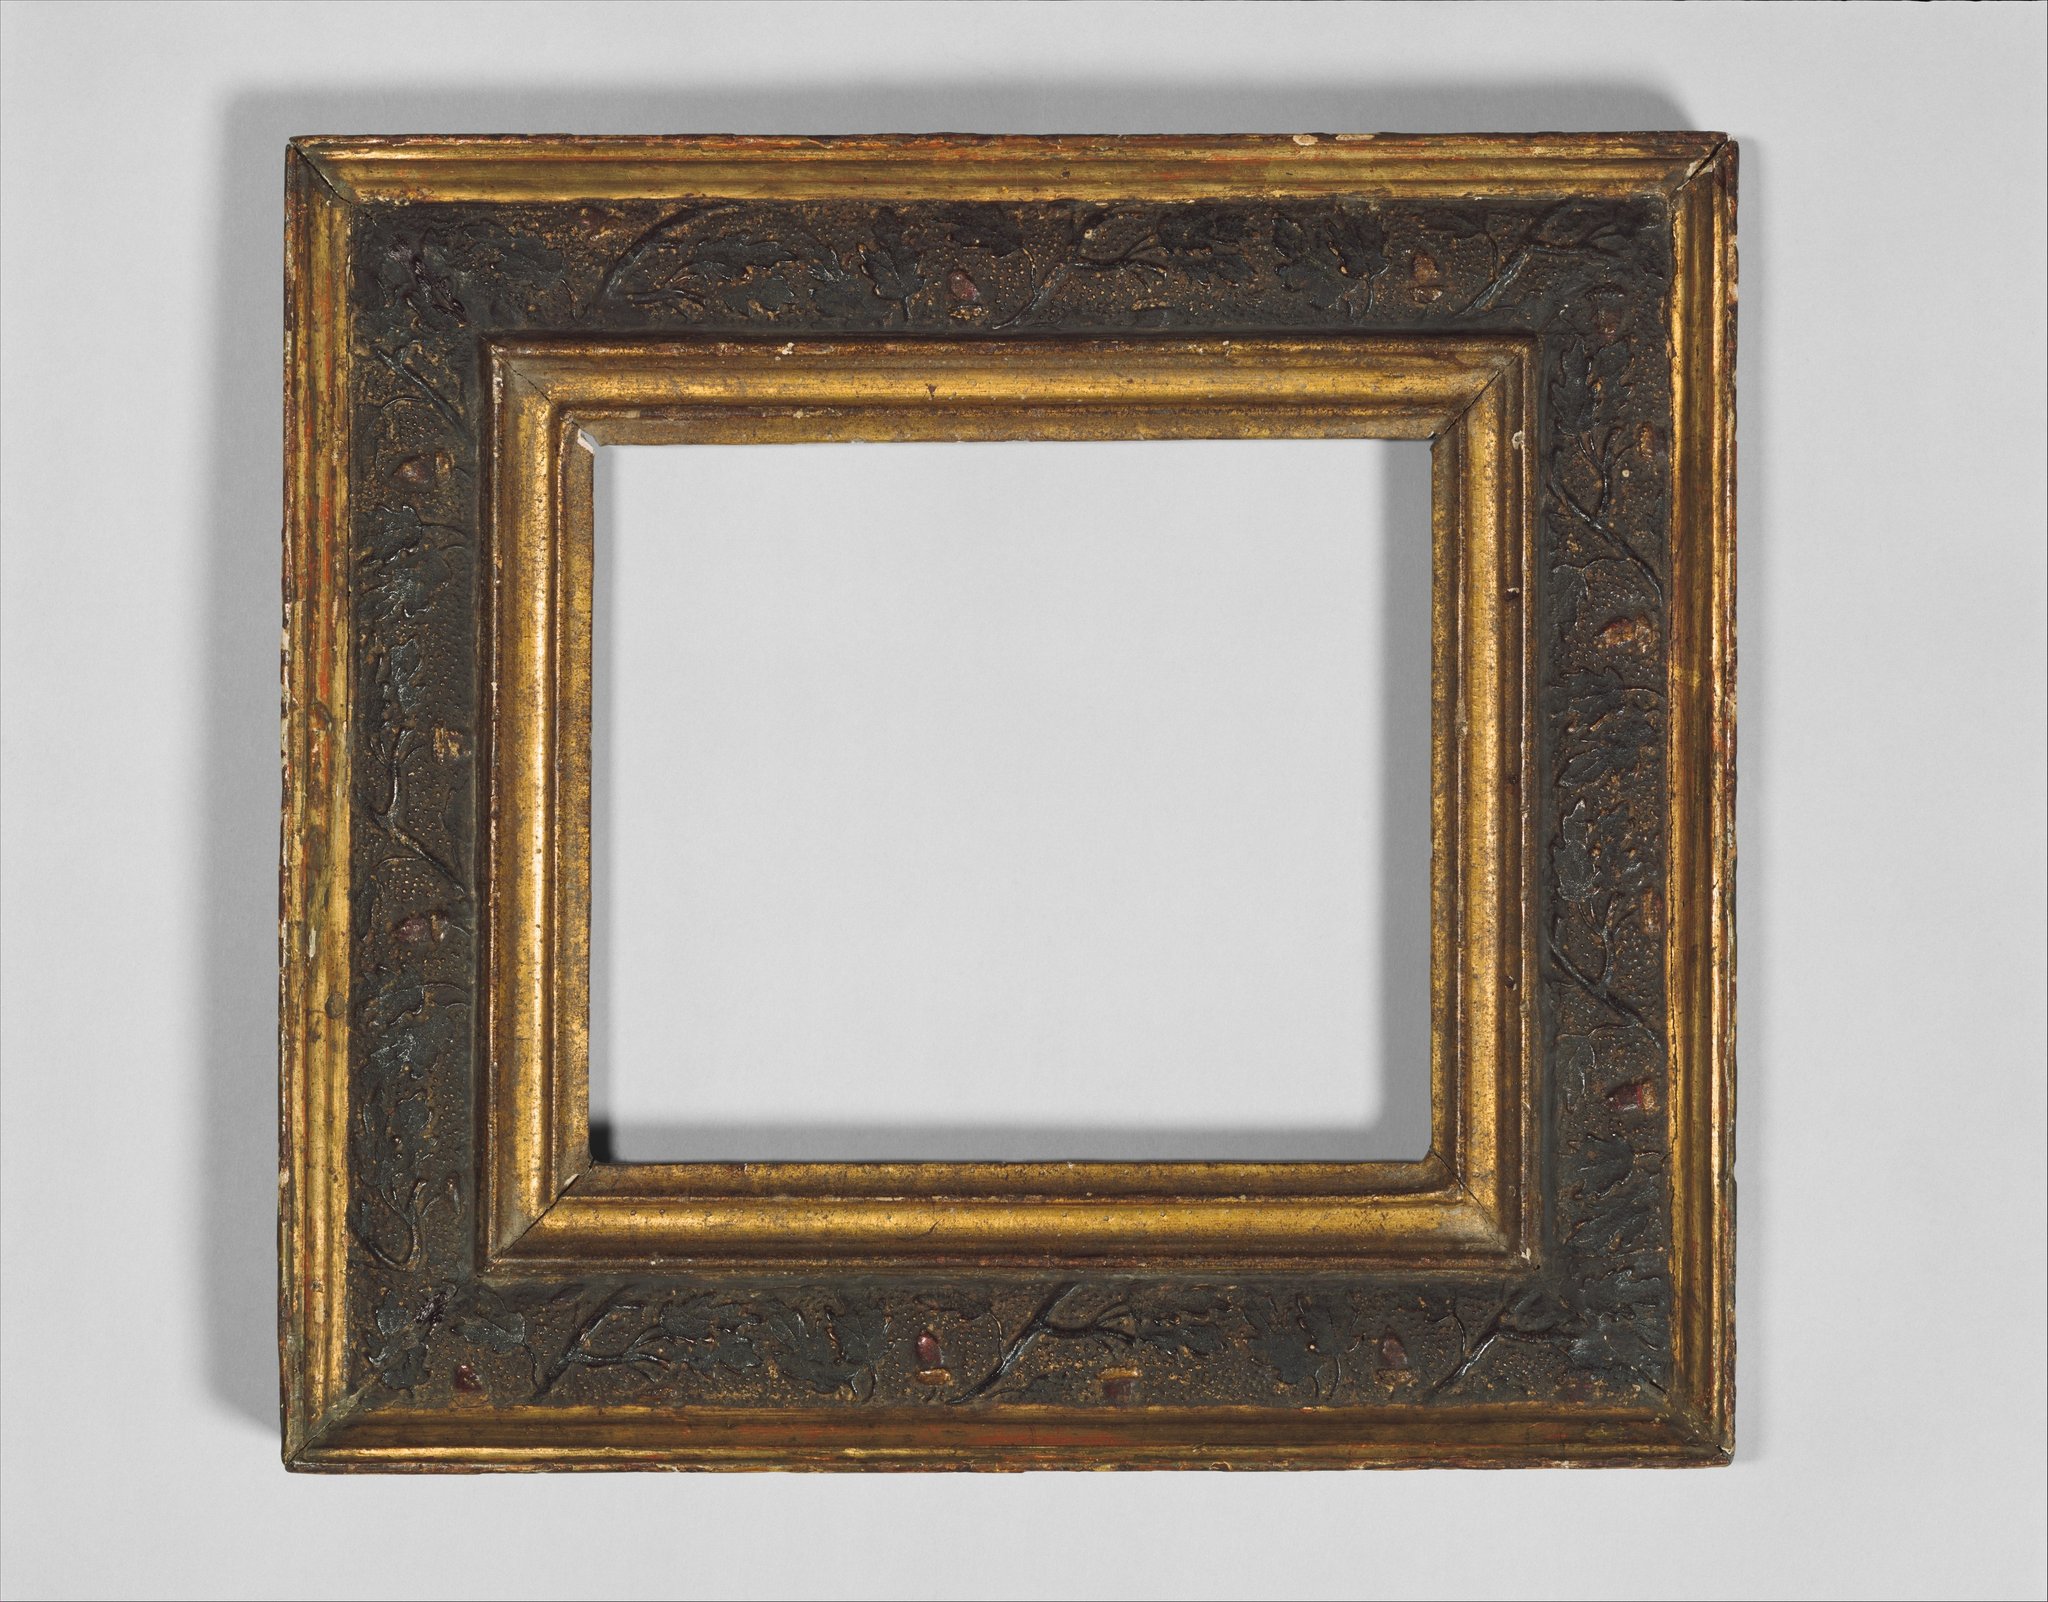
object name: frame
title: Cassetta frame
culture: italian, veneto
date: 1534-1566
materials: wood